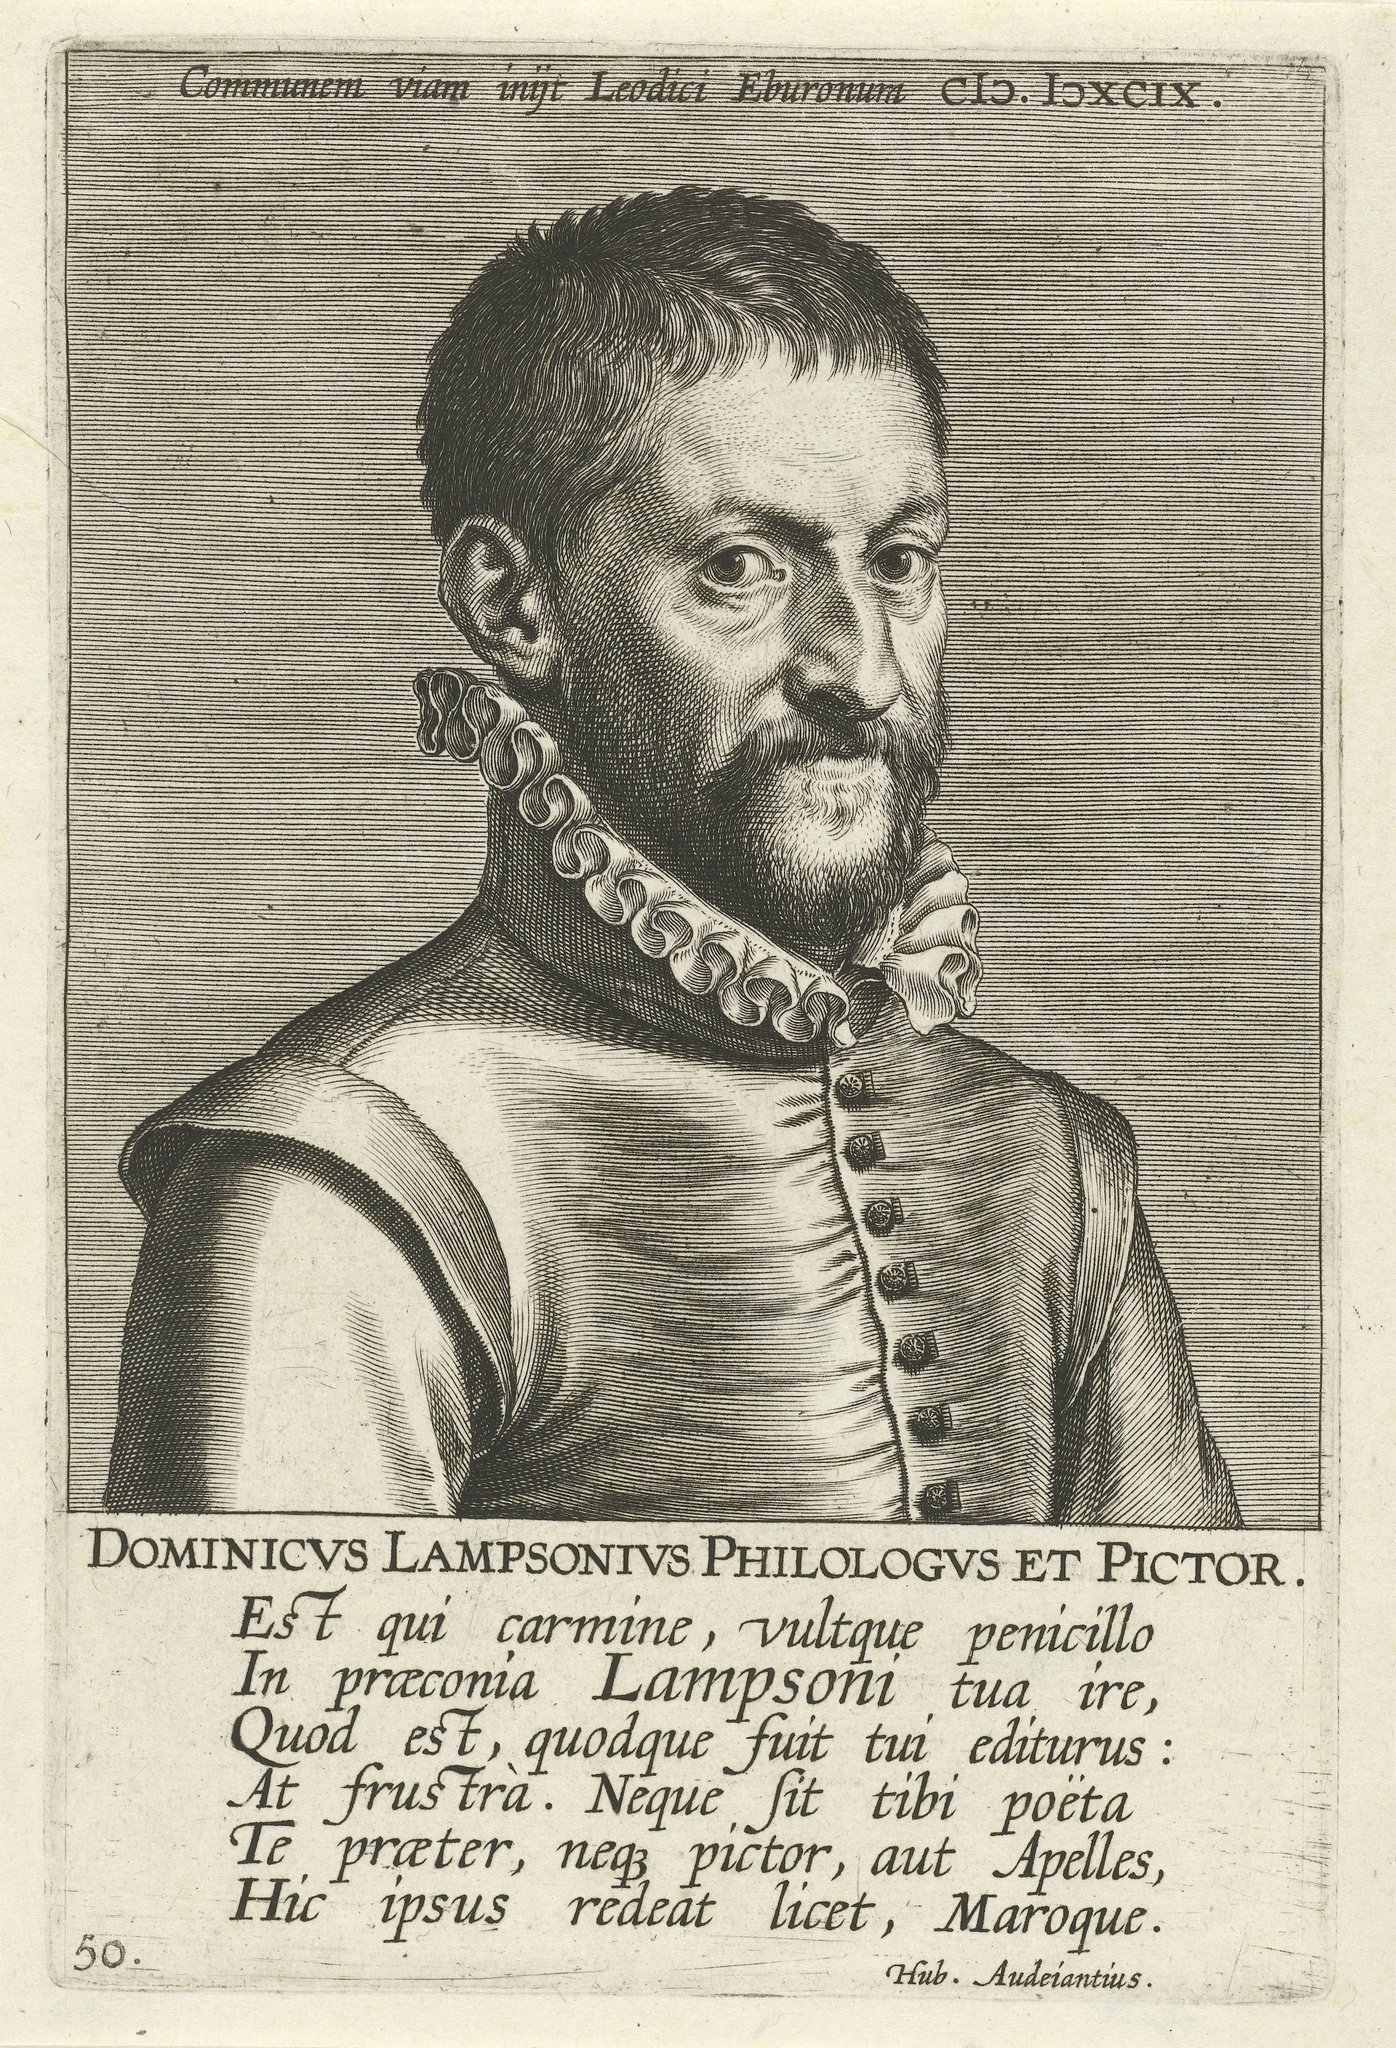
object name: print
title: Portret van Dominique Lampsonius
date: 1604-1608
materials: paper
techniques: engraving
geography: antwerp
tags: bruges, liège, draughtsman, dominicus lampsonius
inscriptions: collector's mark: Lugt 2228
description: Portret van Dominique Lampsonius, bekende schilder en schrijver. Buste naar rechts. De prent heeft een Latijns boven- en onderschrift en maakt deel uit van een serie van beroemde Nederlandse en Vlaamse geleerden.